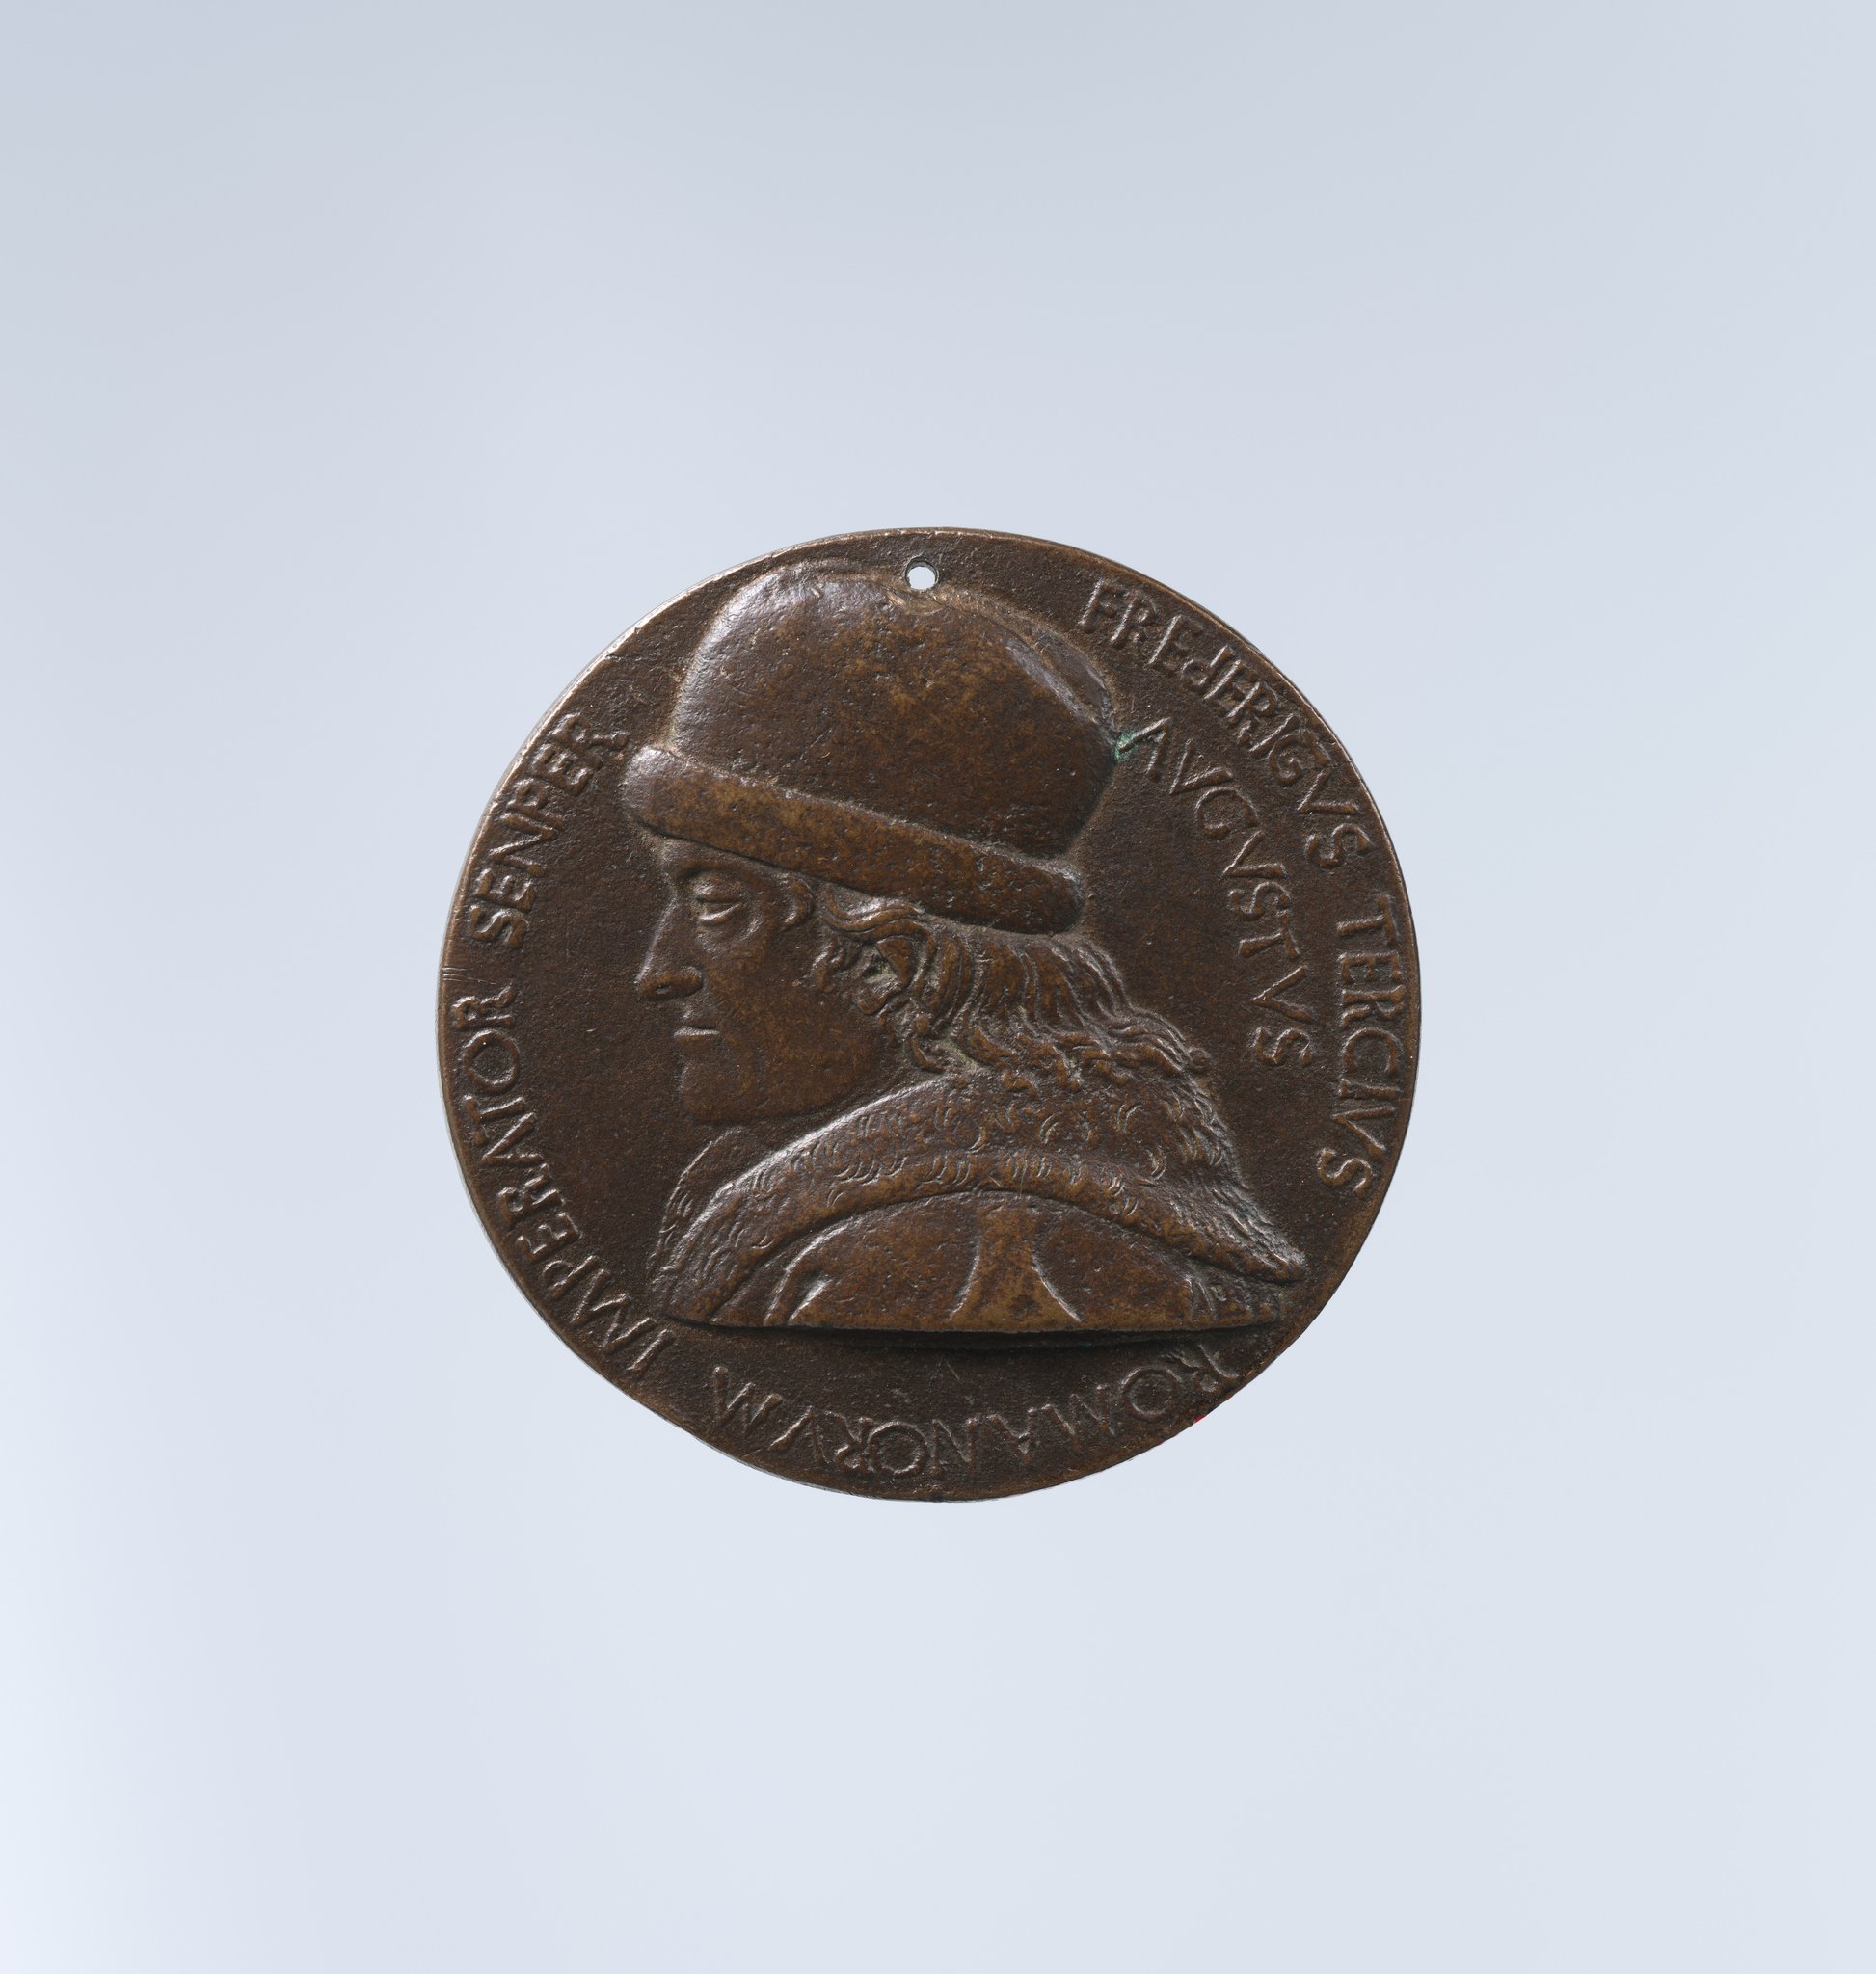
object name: medal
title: Frederick III (1413-1493), Holy Roman Emperor (1452)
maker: bertoldo di giovanni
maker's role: maker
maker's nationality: italian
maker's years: 1430-1491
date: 1469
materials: bronze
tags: kings,profiles,horses